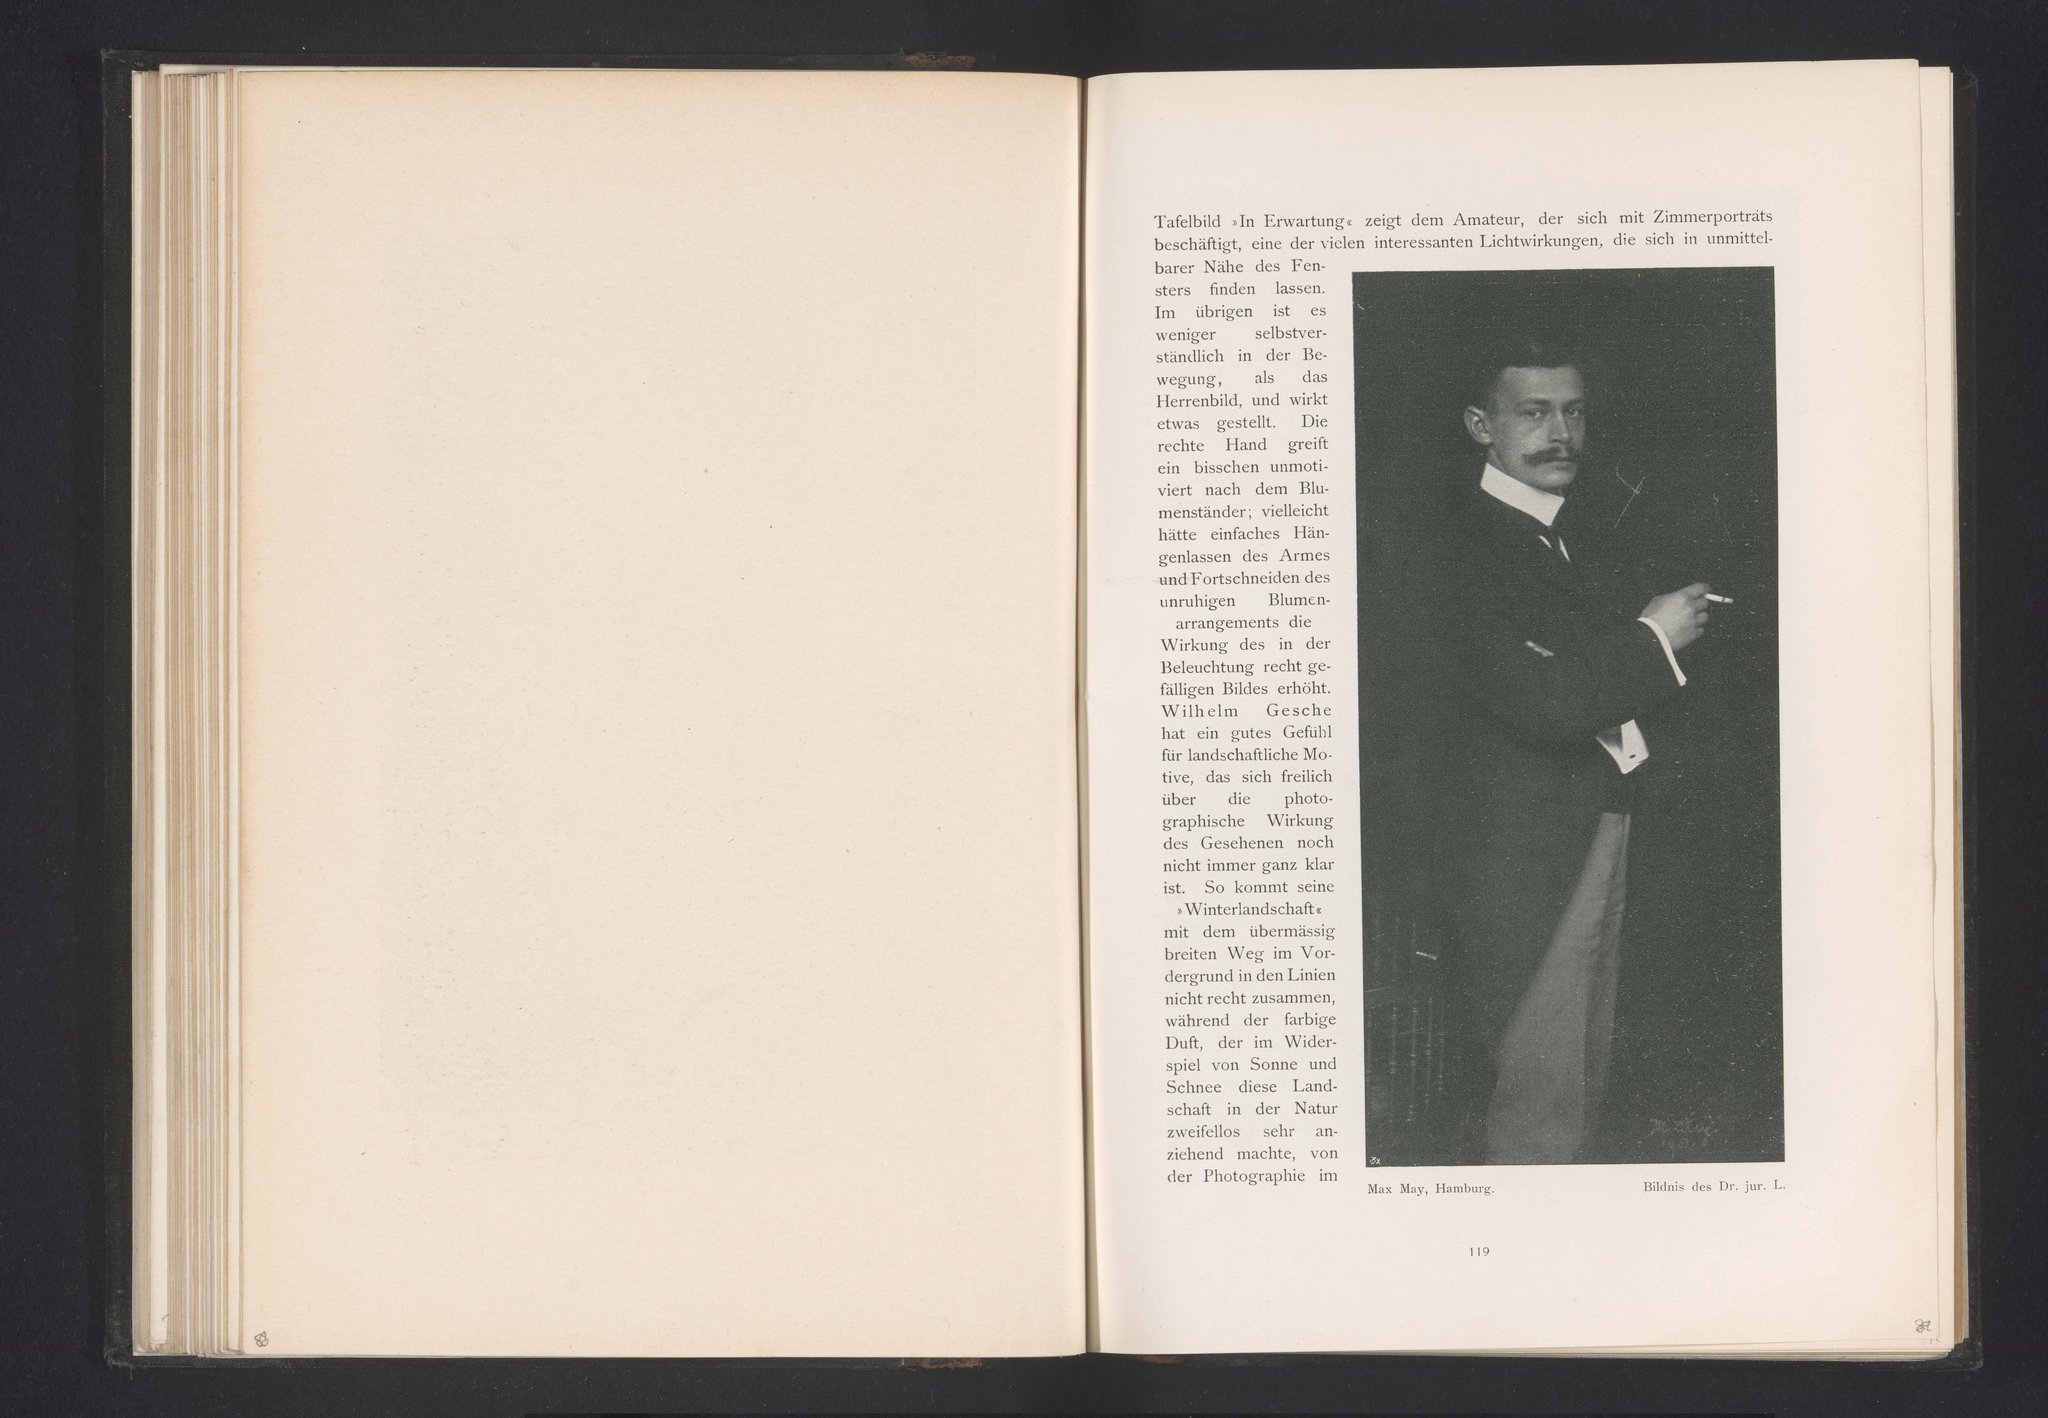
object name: page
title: Bildnis des Dr. jur. L.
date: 1898-1903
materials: paper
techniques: autotype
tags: historical persons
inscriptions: monogram: ‘BX’, inscription: ‘Hamburg’